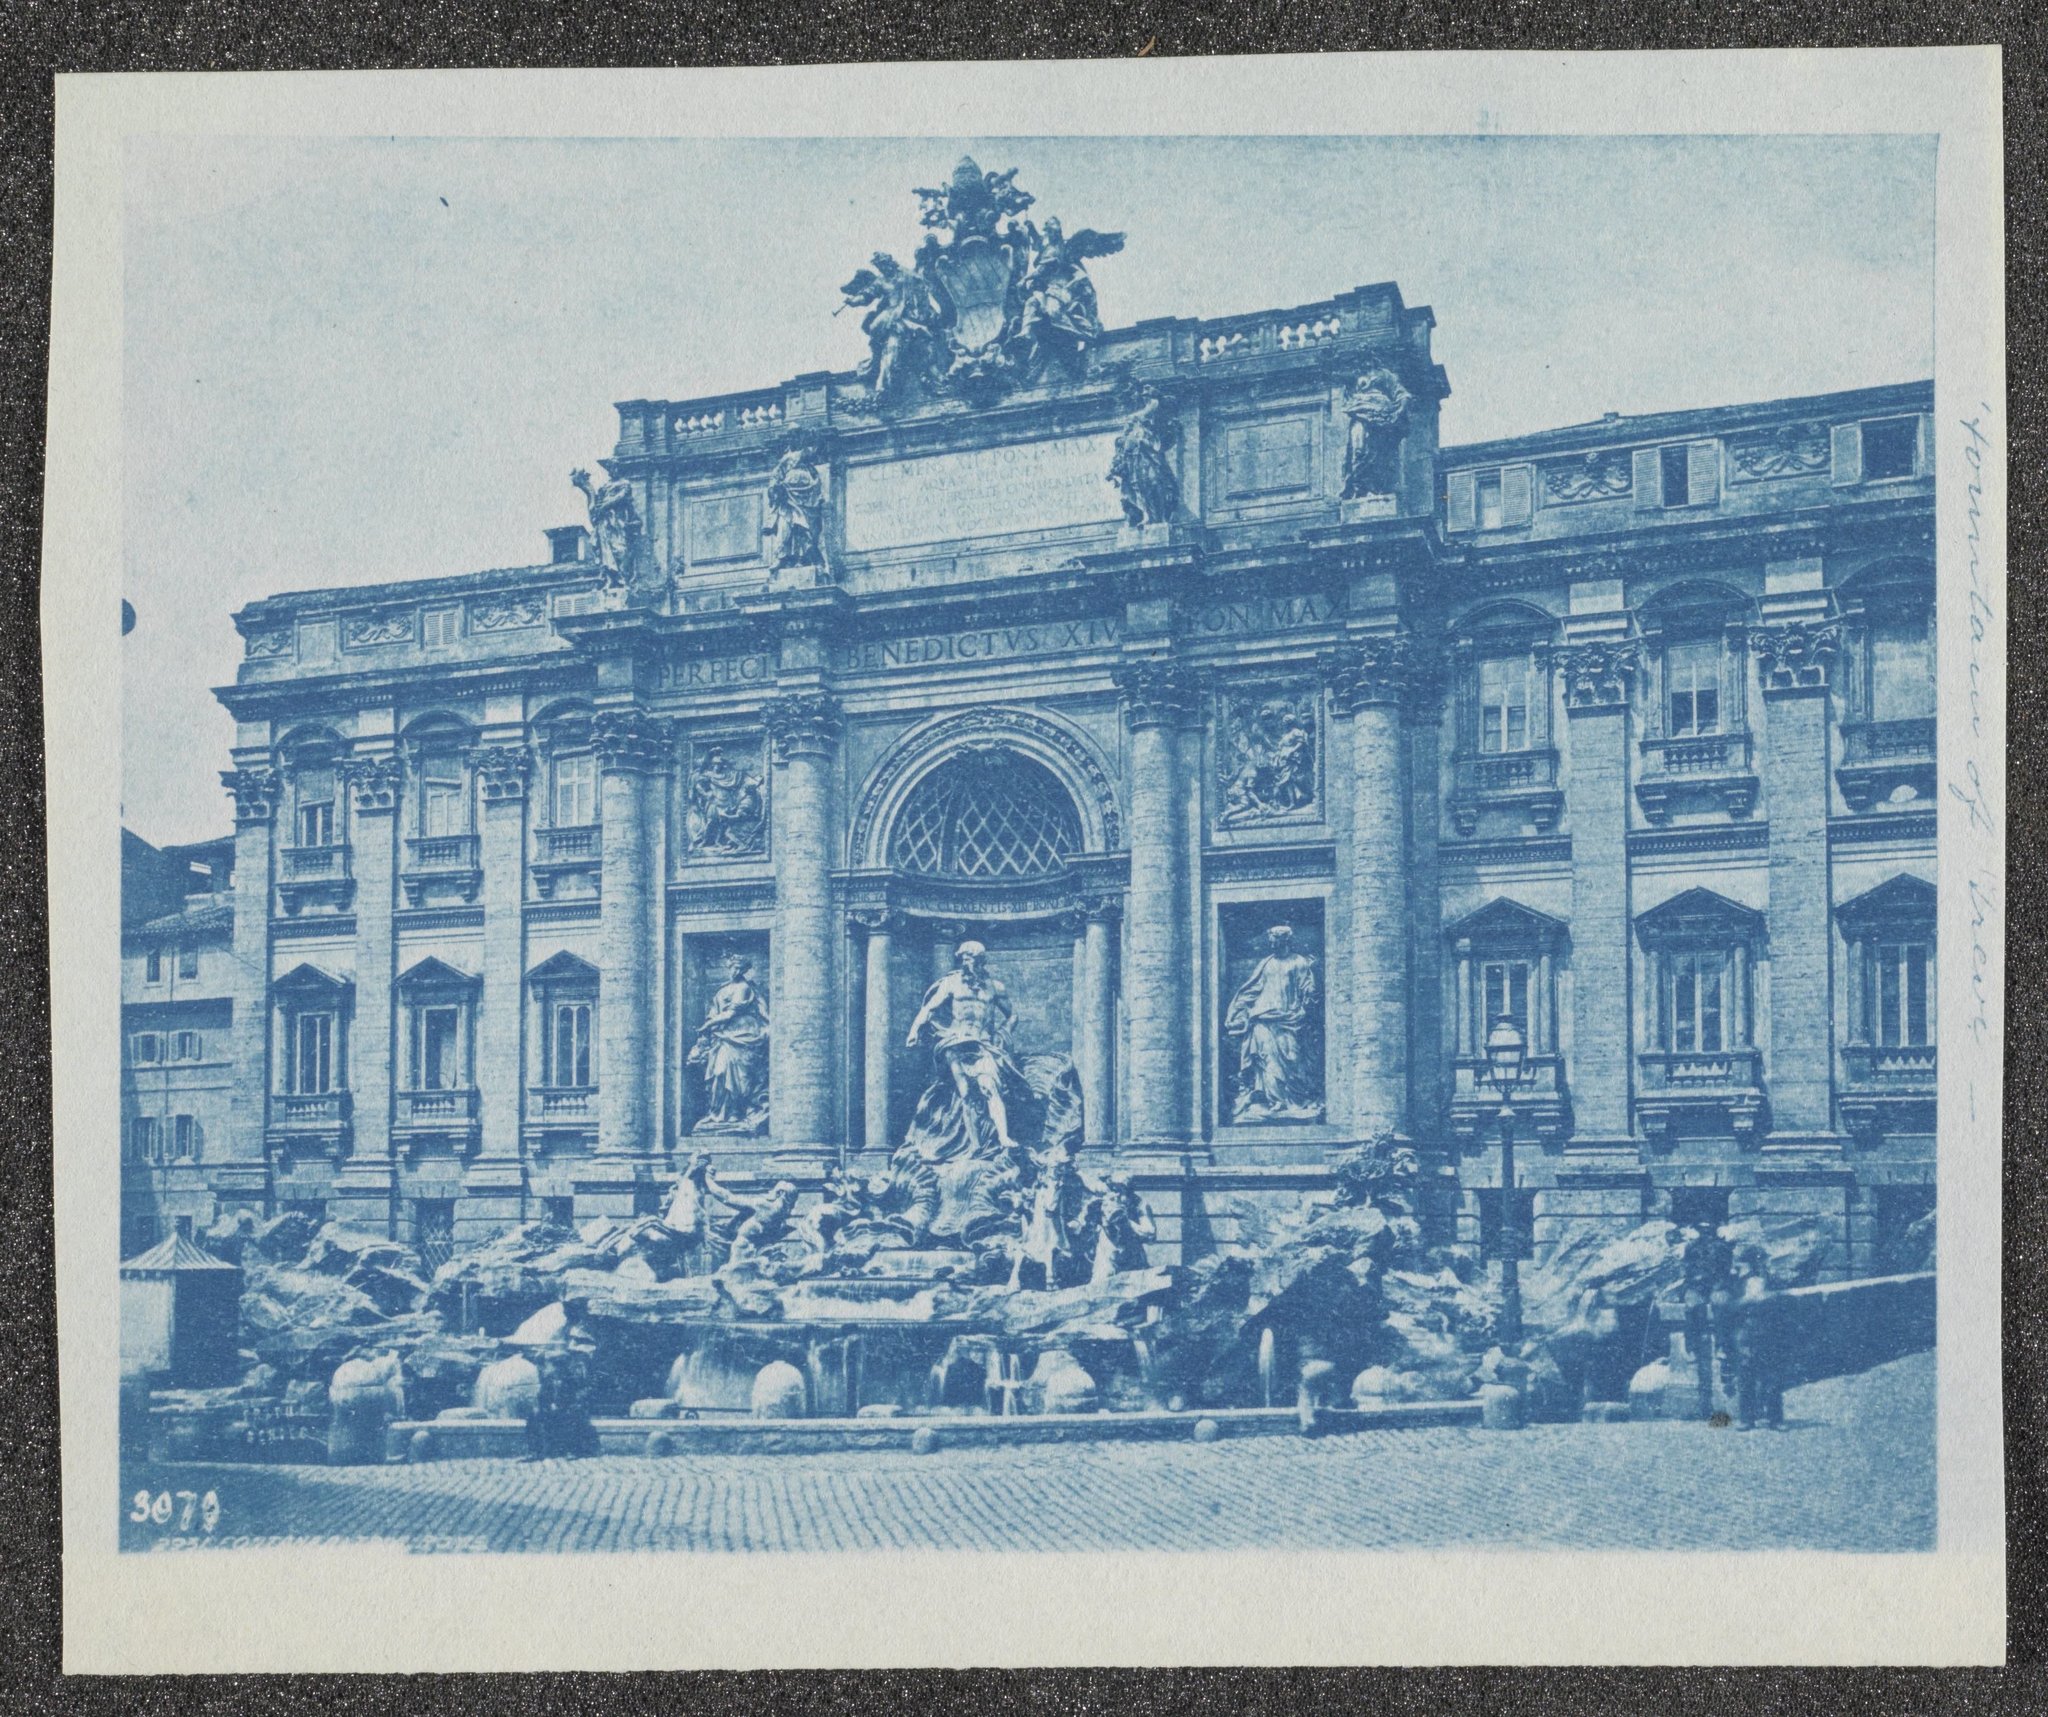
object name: photograph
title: Fotoreproductie van een foto van de Trevifontein te Rome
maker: Anonymous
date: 1880-1905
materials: paper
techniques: cyanotype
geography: rome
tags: ornamental fountain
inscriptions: number: ‘3079’, inscription: ‘Trevi Fountain/ Rome/ 3071/ Lesson II/ One who drops a penny/ here has his return/ to Rome assured.’